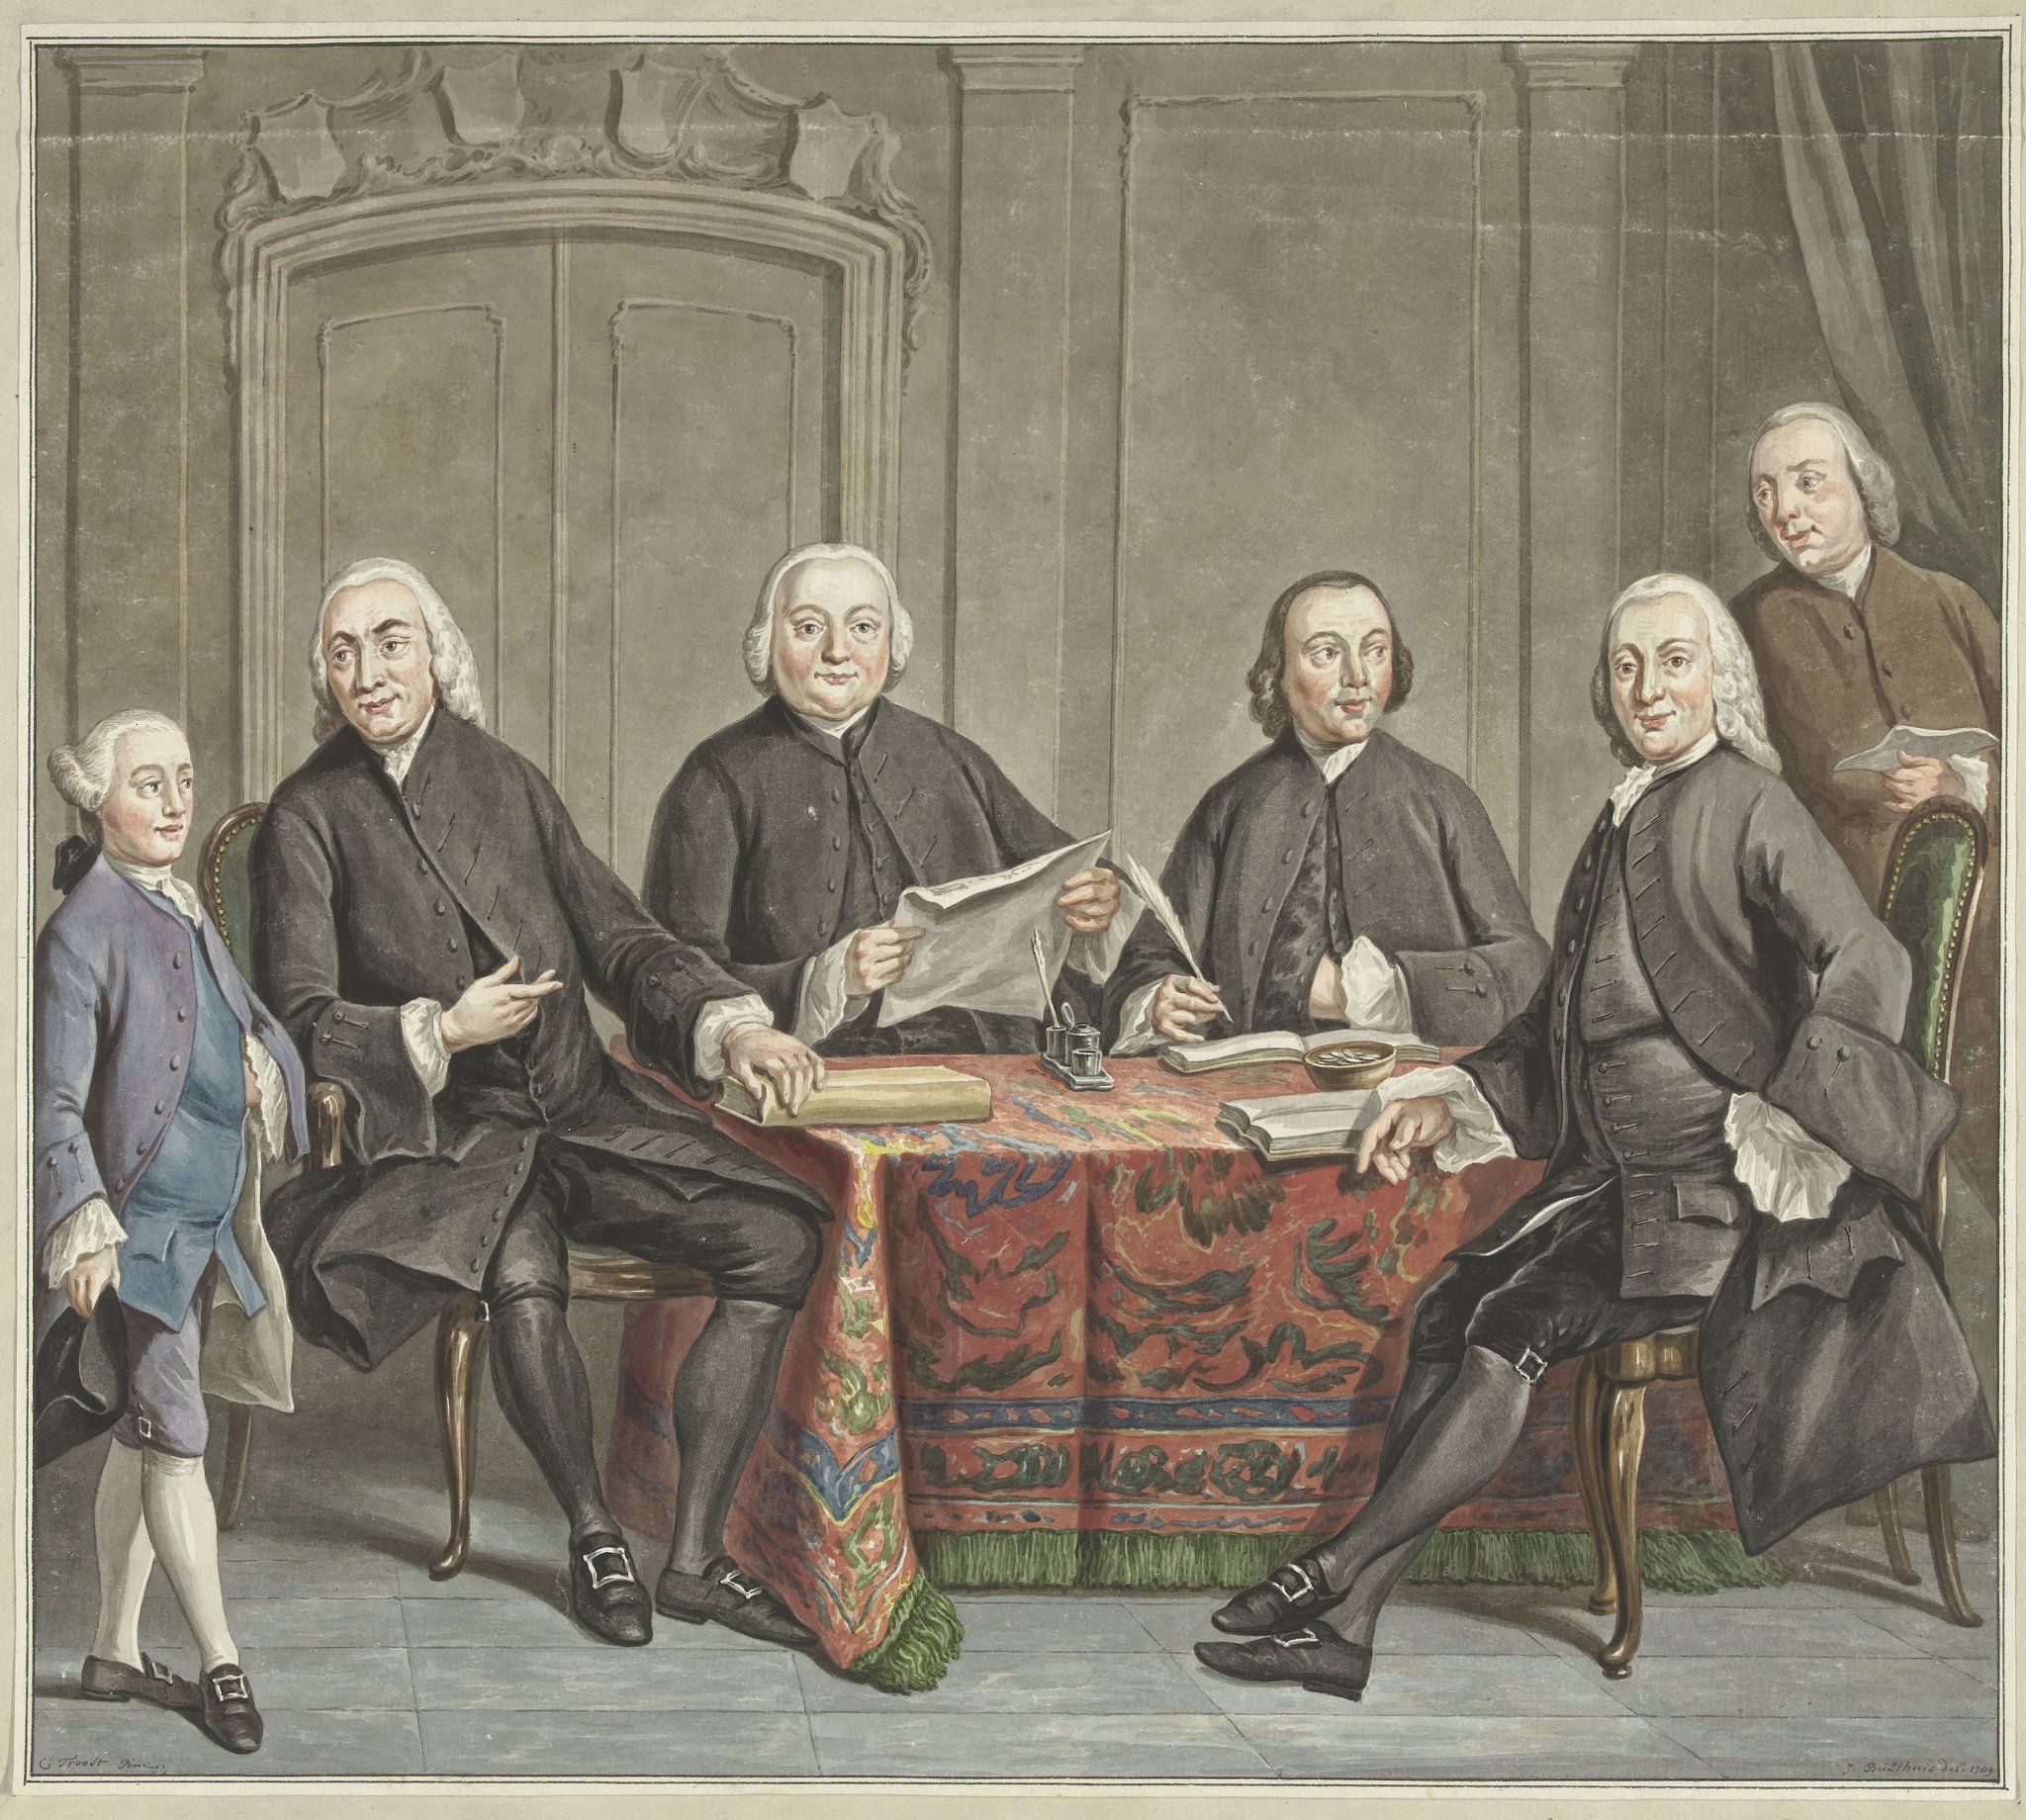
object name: drawing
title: Regentenstuk, 1789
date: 1789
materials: paper, watercolor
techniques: brush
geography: northern netherlands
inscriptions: collector's mark: Lugt 2228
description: Regentenstuk uit 1789 met vier onbekende regenten zittend om een tafel, rechts een bediende, links een jonge man.